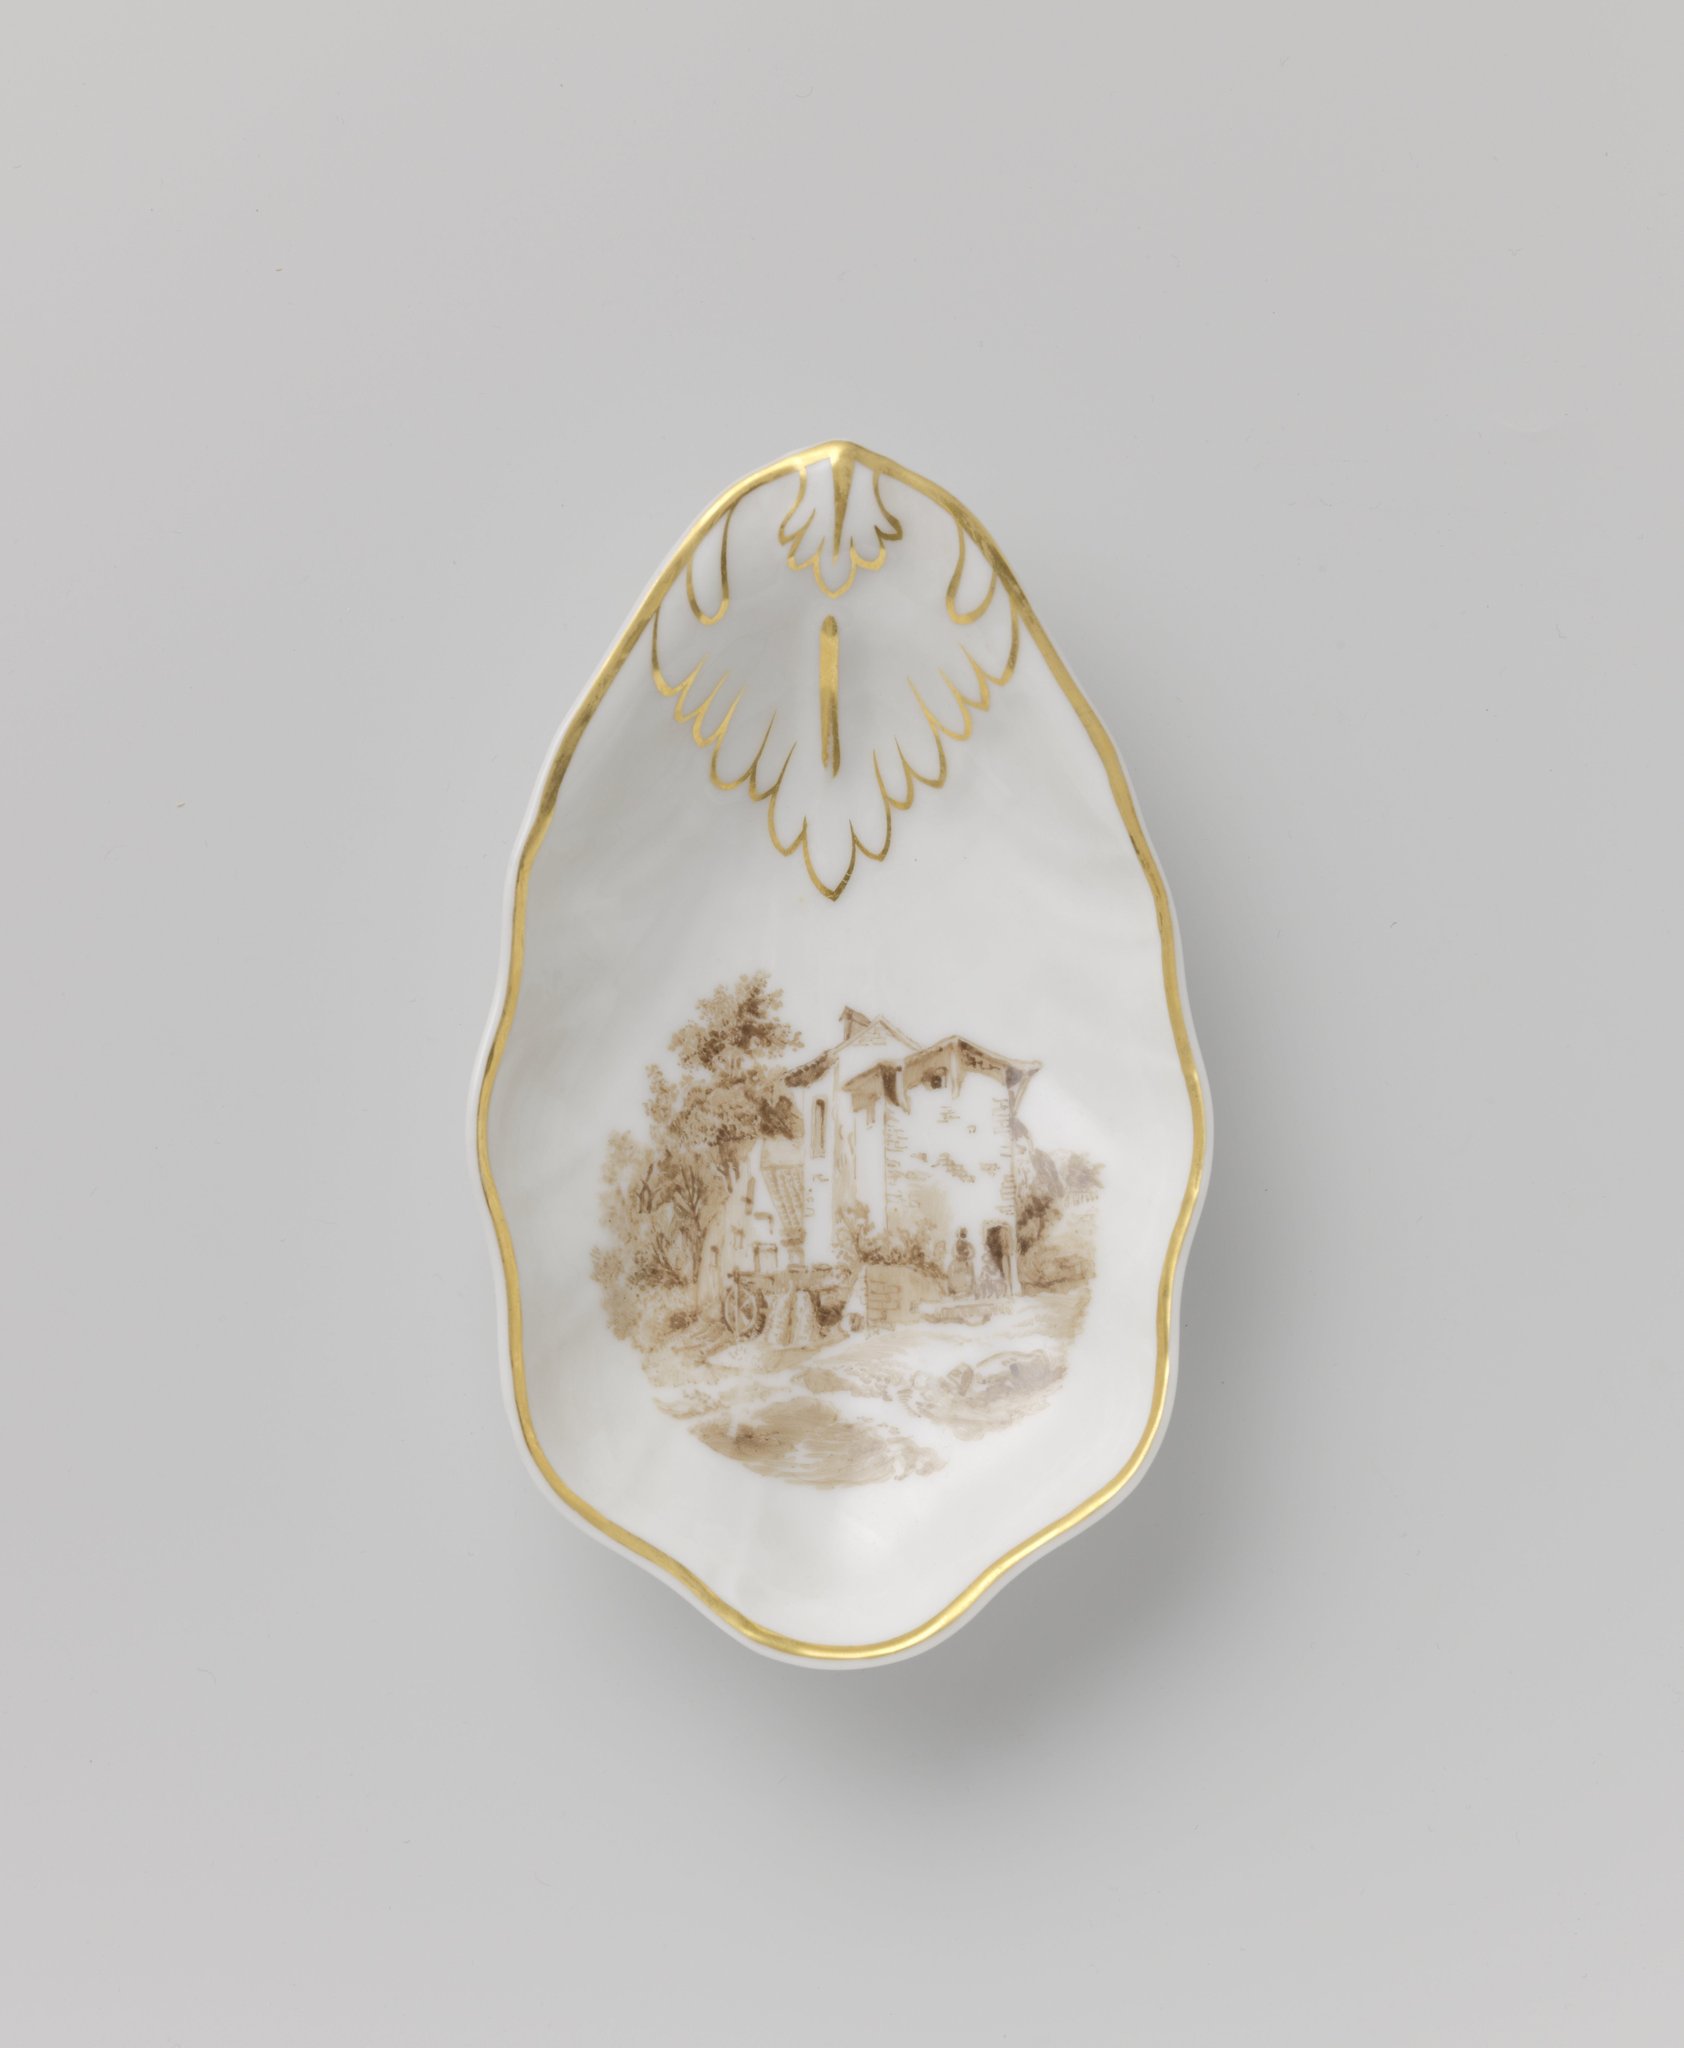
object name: dish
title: Dish with a landscape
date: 1850-1860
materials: glaze, gold, paint, porcelain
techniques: firing, forming, gilding, turning, vitrification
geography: europe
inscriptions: mark: ‘III/ t’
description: Bladvormige schaal van porselein, beschilderd op het glazuur in sepia en goud. Aan één zijde op de voorkant een gemodelleerd blad, aangezet met goud. Op het plat een landschap met twee personen voor een groot gebouw met een waterrad. Gemerkt op de onderzijde met III en t.